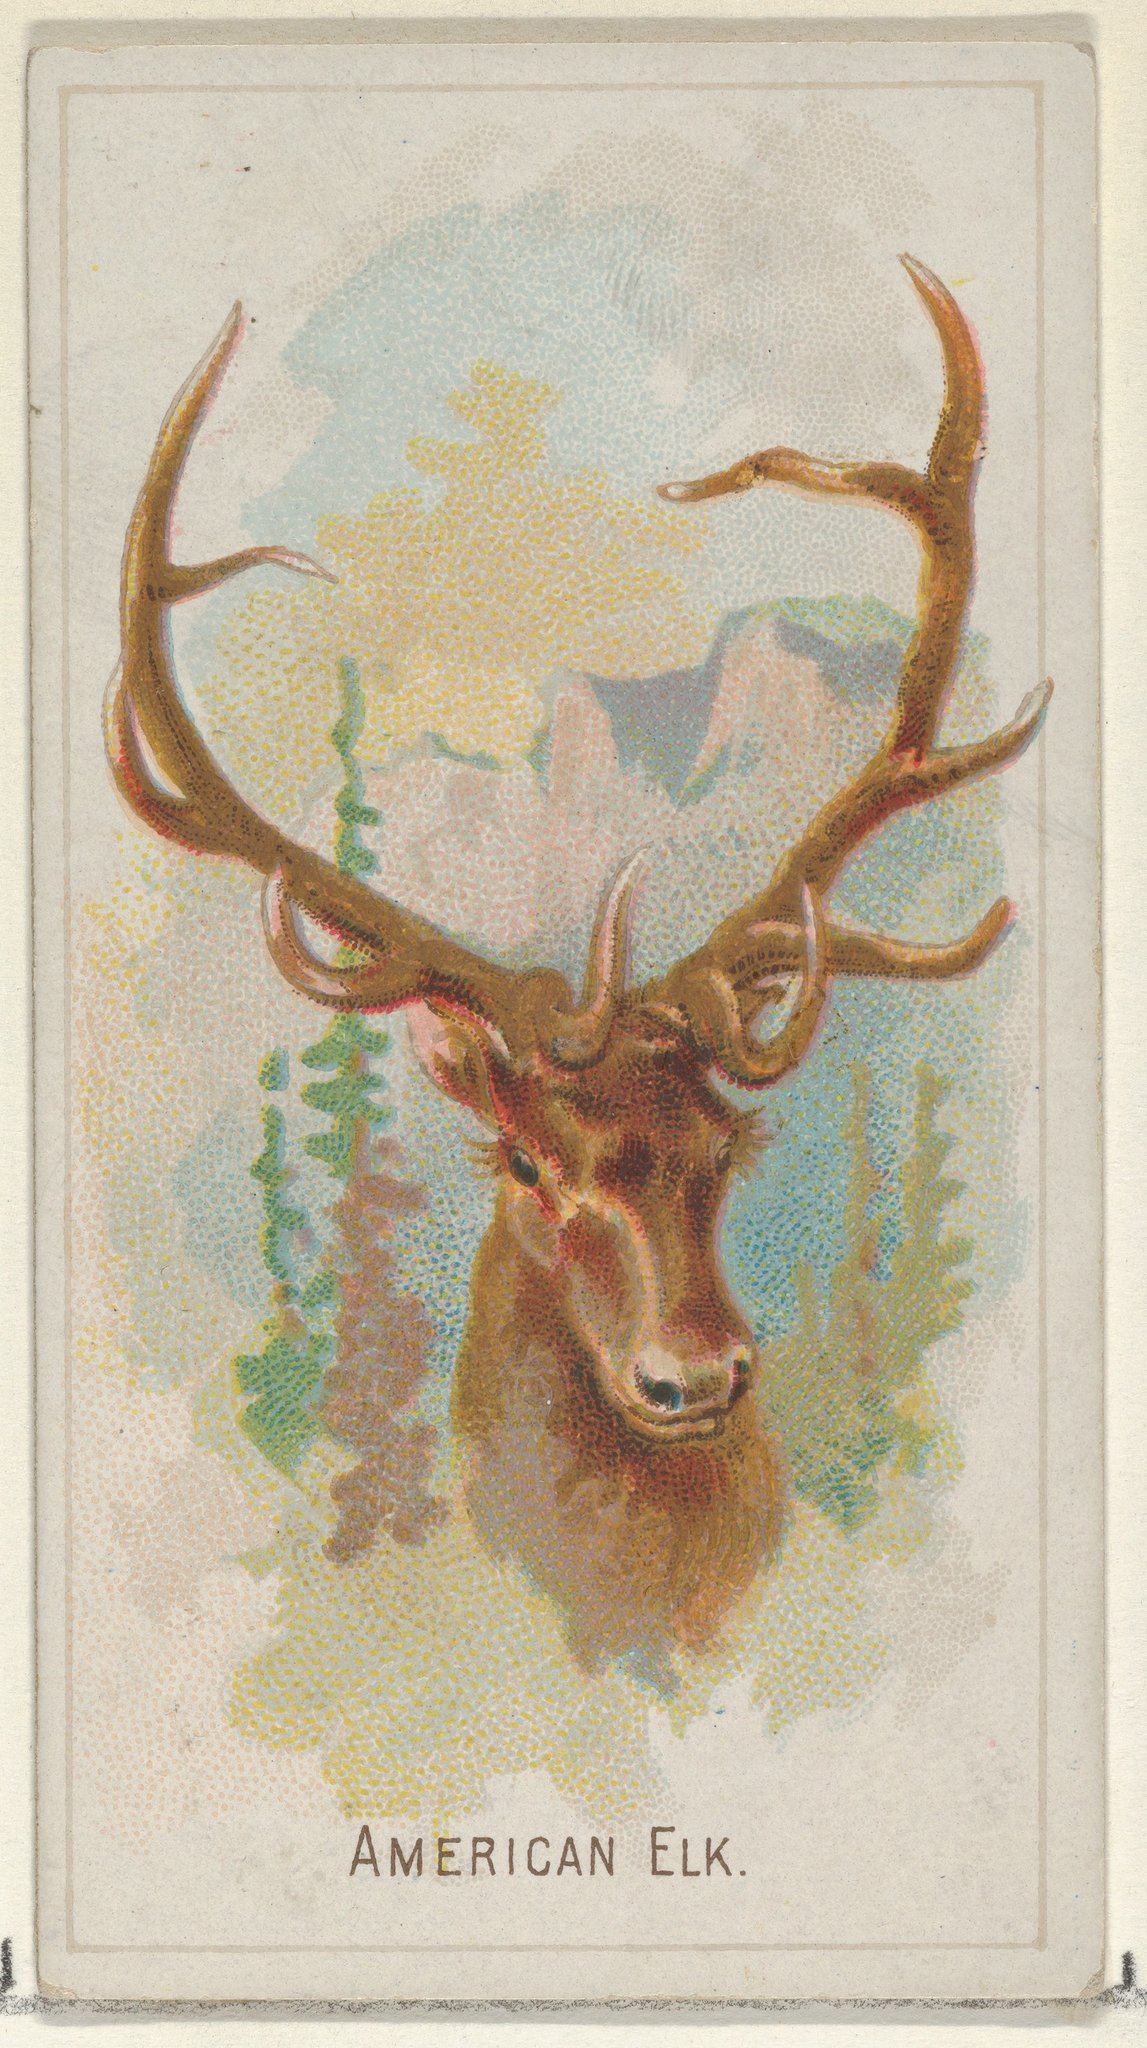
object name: print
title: American Elk, from the Wild Animals of the World series (N25) for Allen & Ginter Cigarettes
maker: allen & ginter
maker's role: publisher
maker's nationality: american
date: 1888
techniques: color lithograph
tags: animals